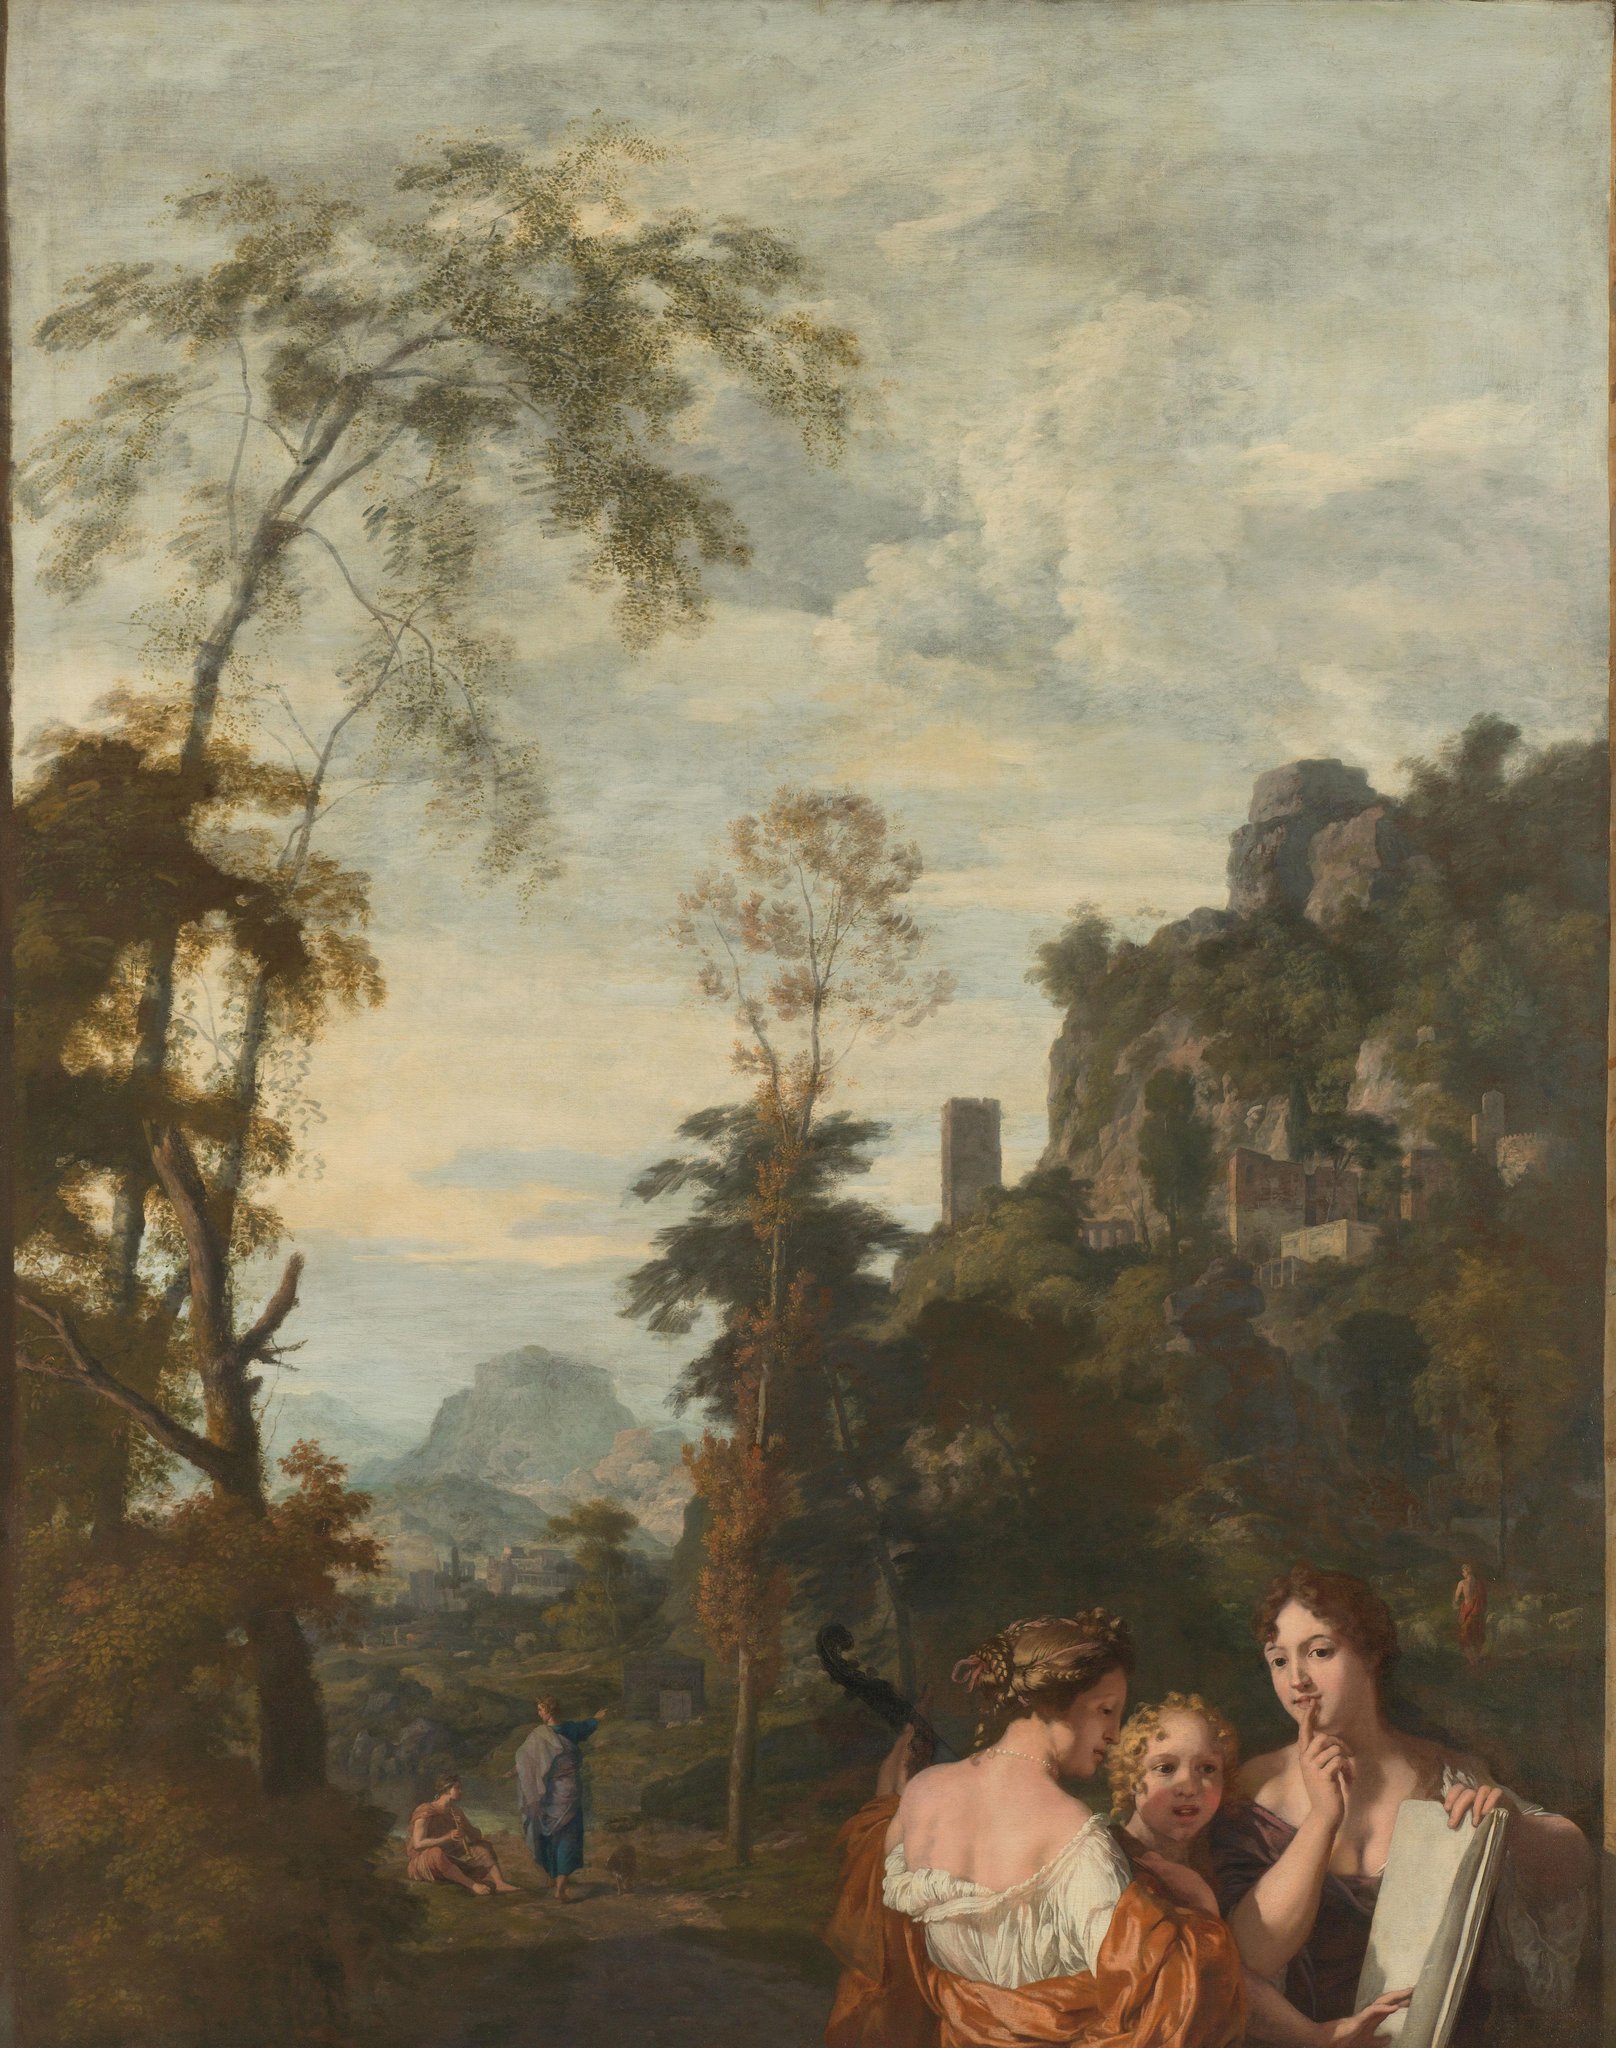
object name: painting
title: Italian Landscape with three Women Making Music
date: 1687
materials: canvas, oil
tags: vocal music, singing - cc - out of doors, pastorals, arcadian scenes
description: Gerard Lairesse (1641 - 1711) and Johannes Glauber (1646 - c. 1726). Italian landscape with three women making music.